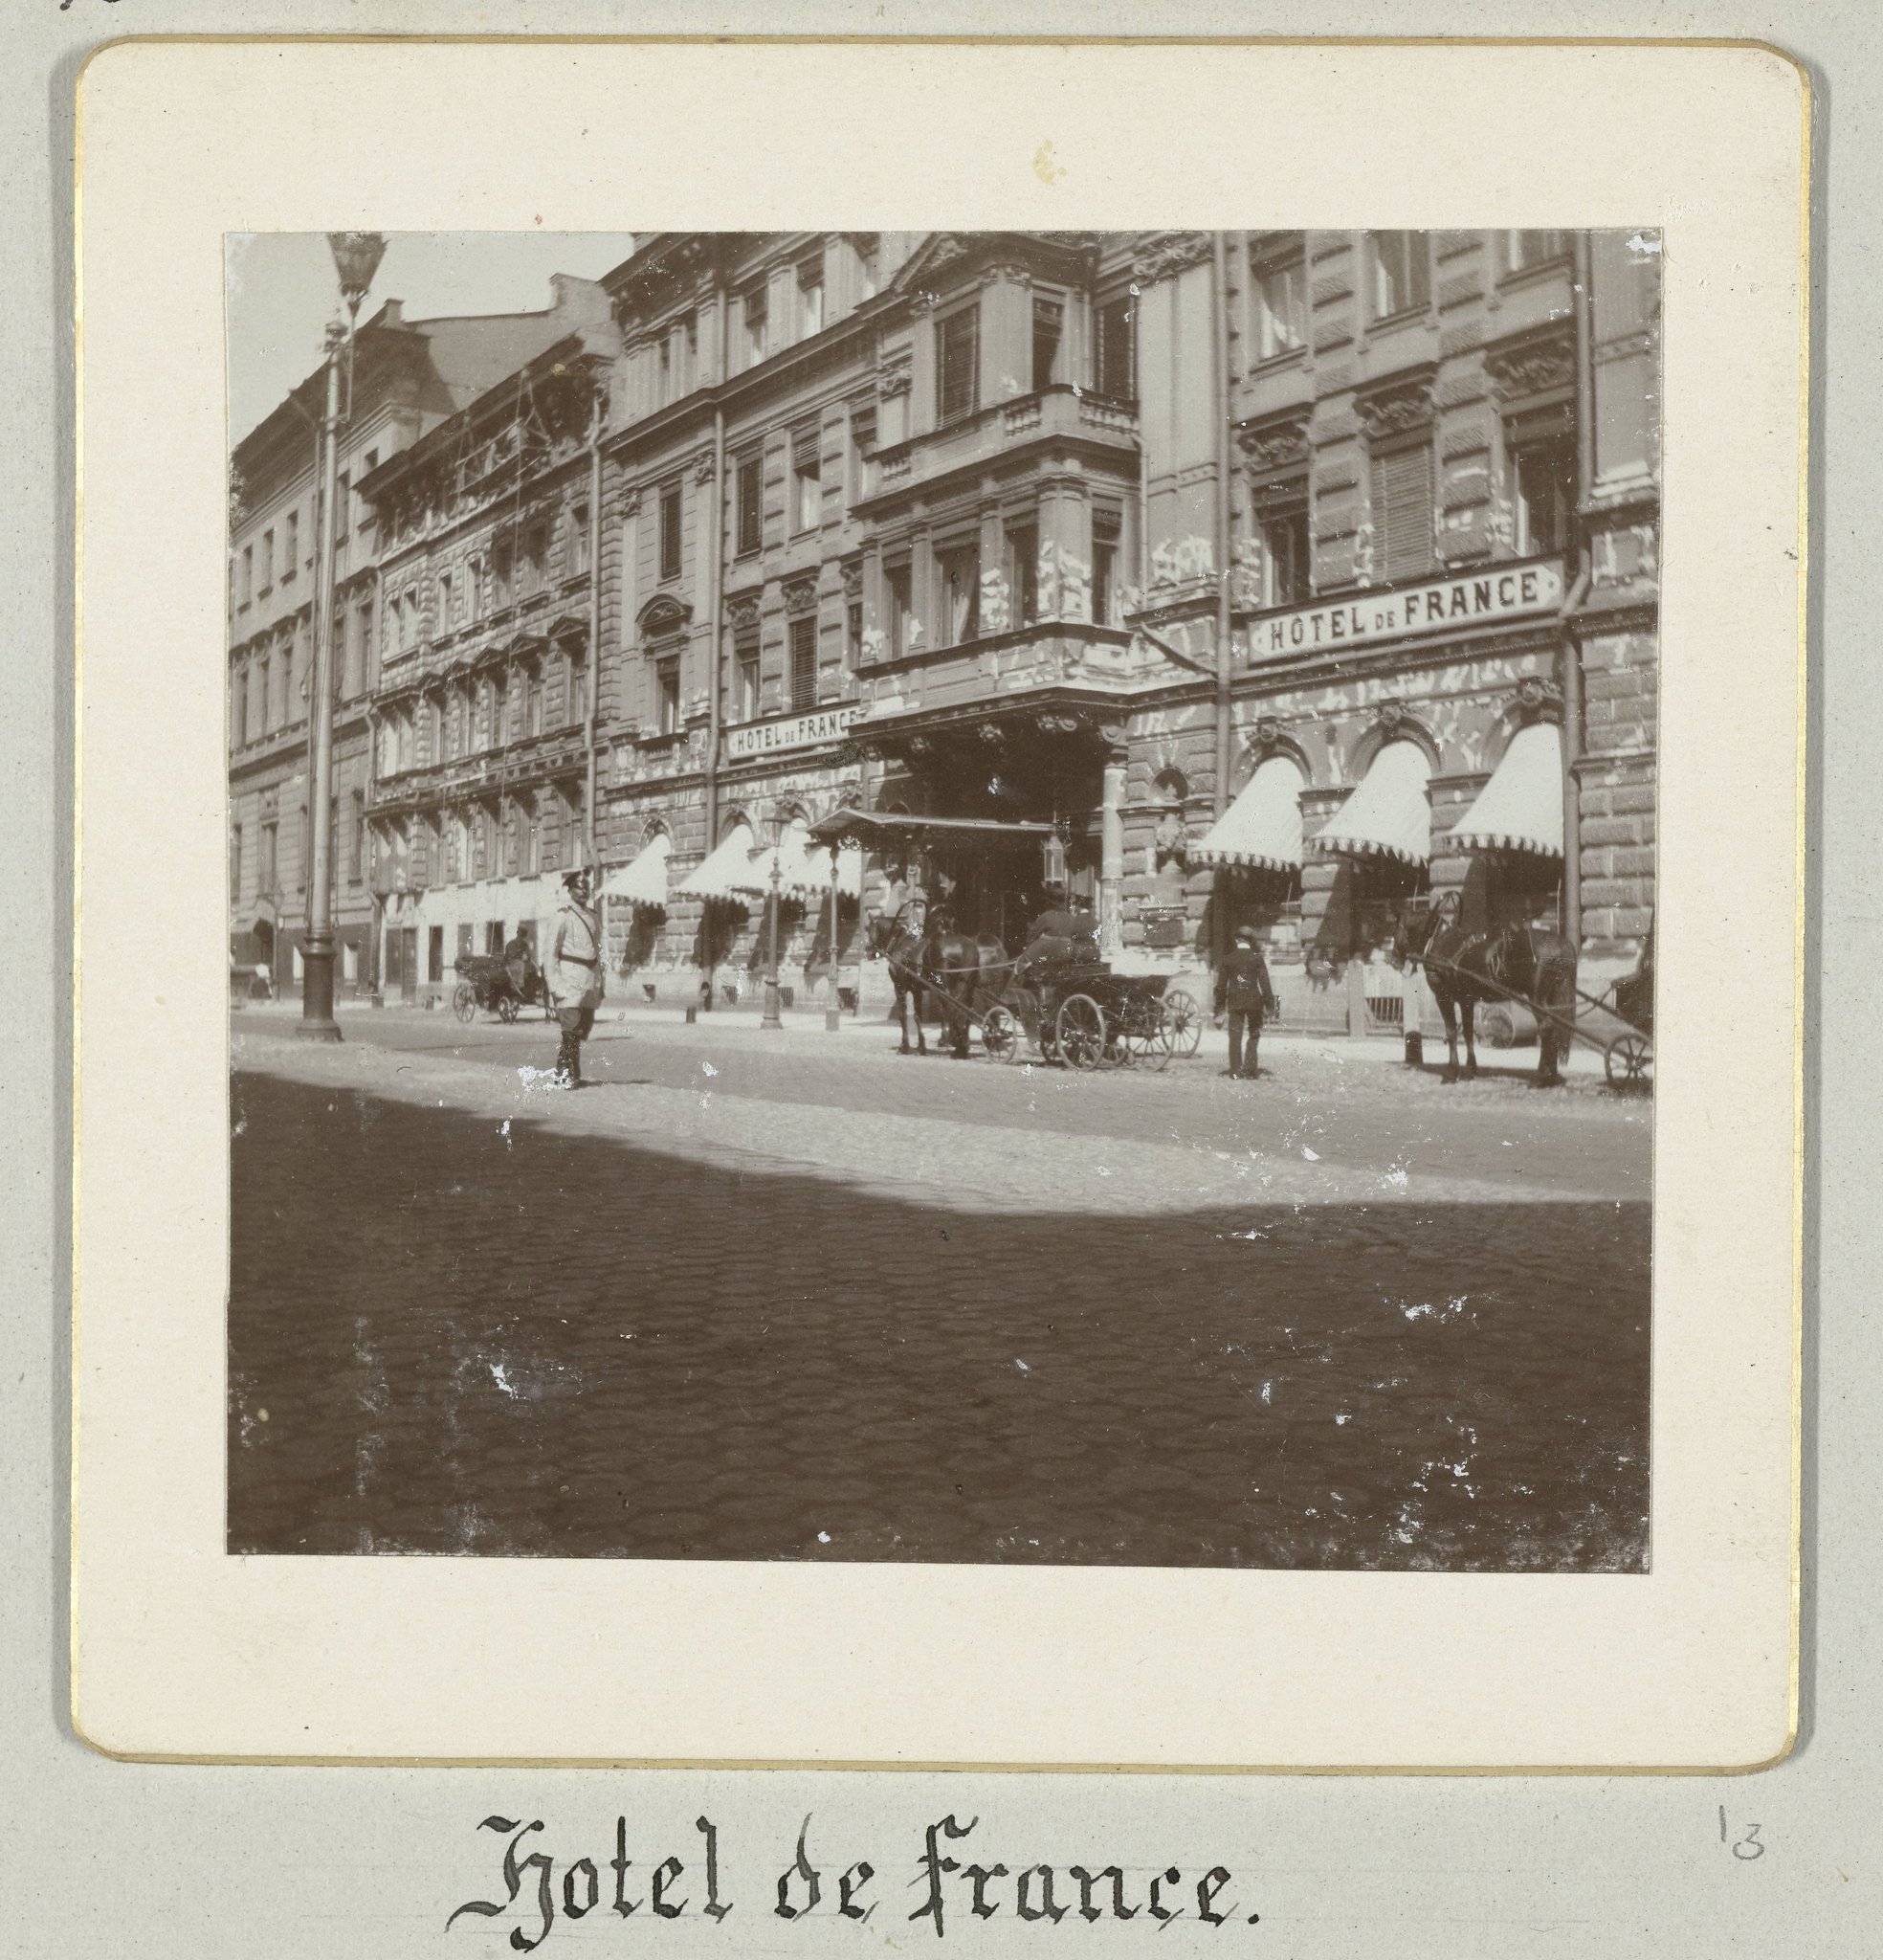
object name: photograph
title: St Petersburg, hotel de France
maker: henry pauw van wieldrecht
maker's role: fotograaf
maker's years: 1863-1912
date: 1898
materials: paper, photographic support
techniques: albumen print